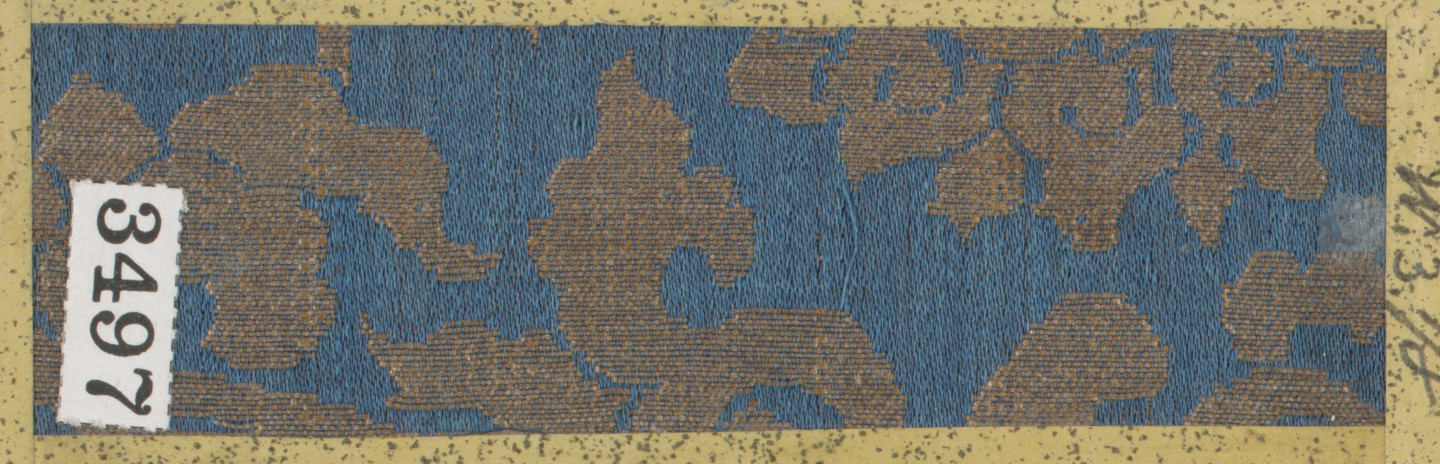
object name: sample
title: Textile Sample from Sample Book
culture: japanese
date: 1801-1900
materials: silk